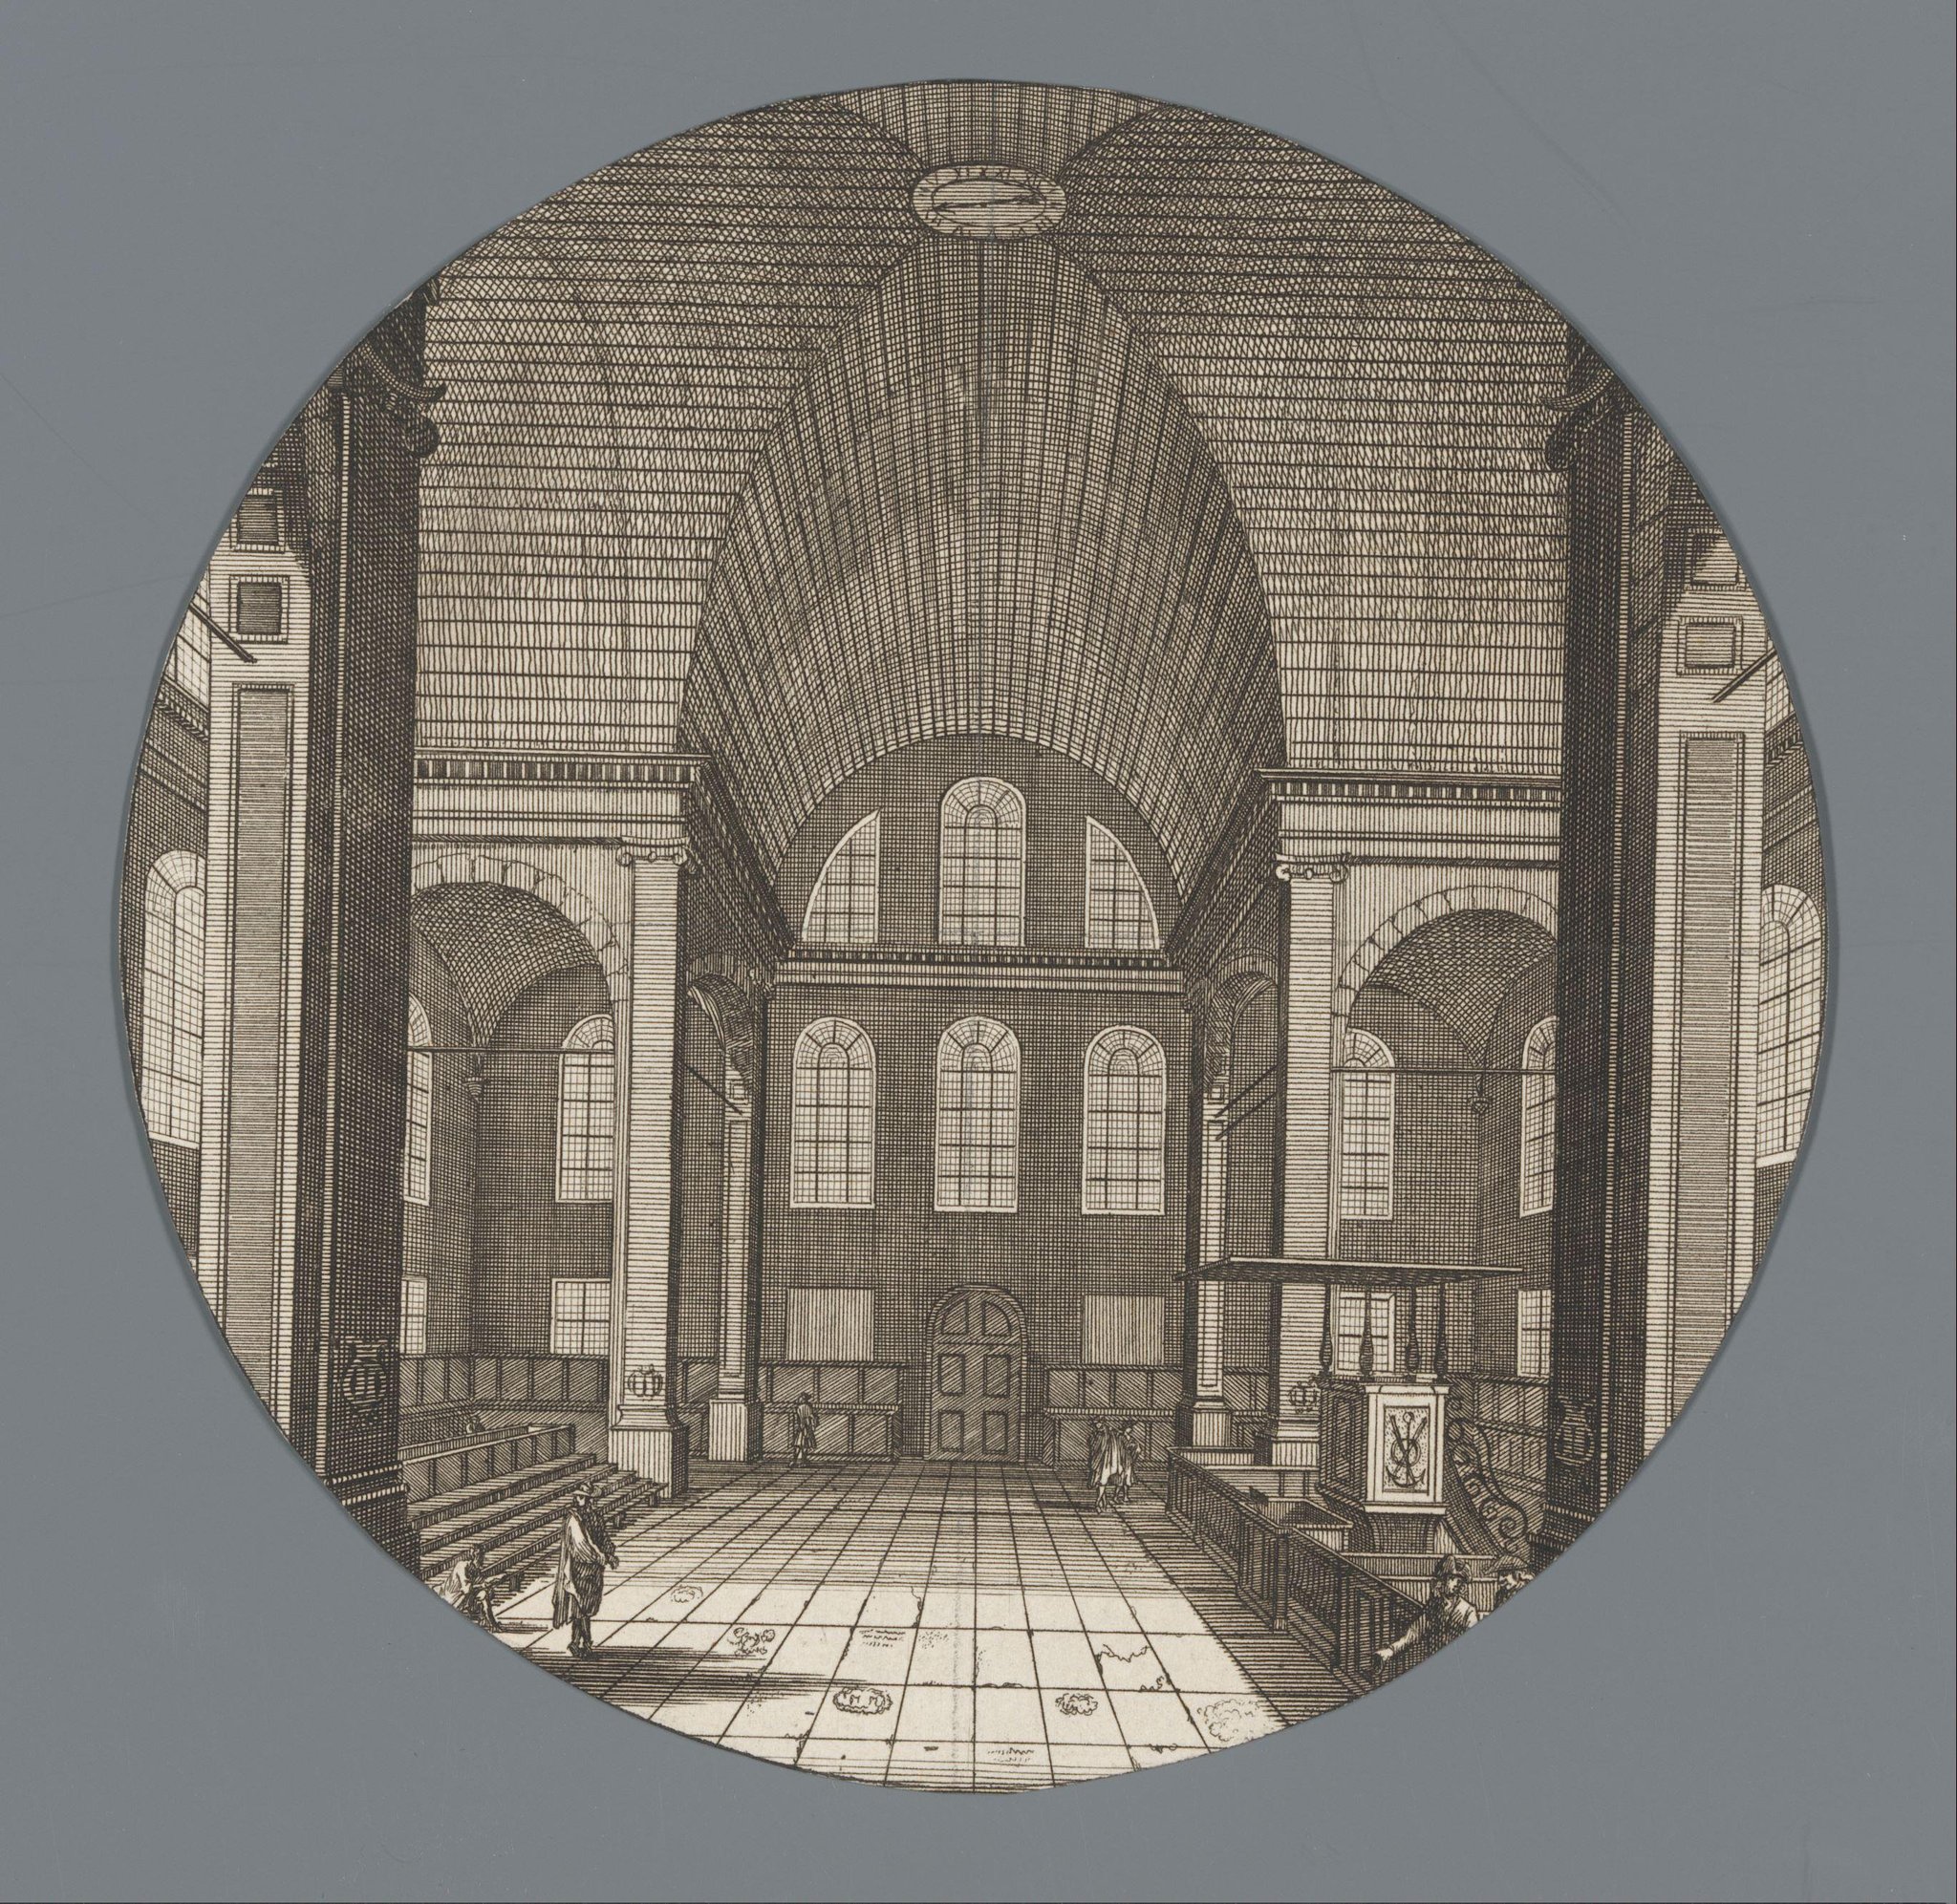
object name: print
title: Kerkinterieur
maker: Anonymous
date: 1650-1800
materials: paper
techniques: etching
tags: interior of church